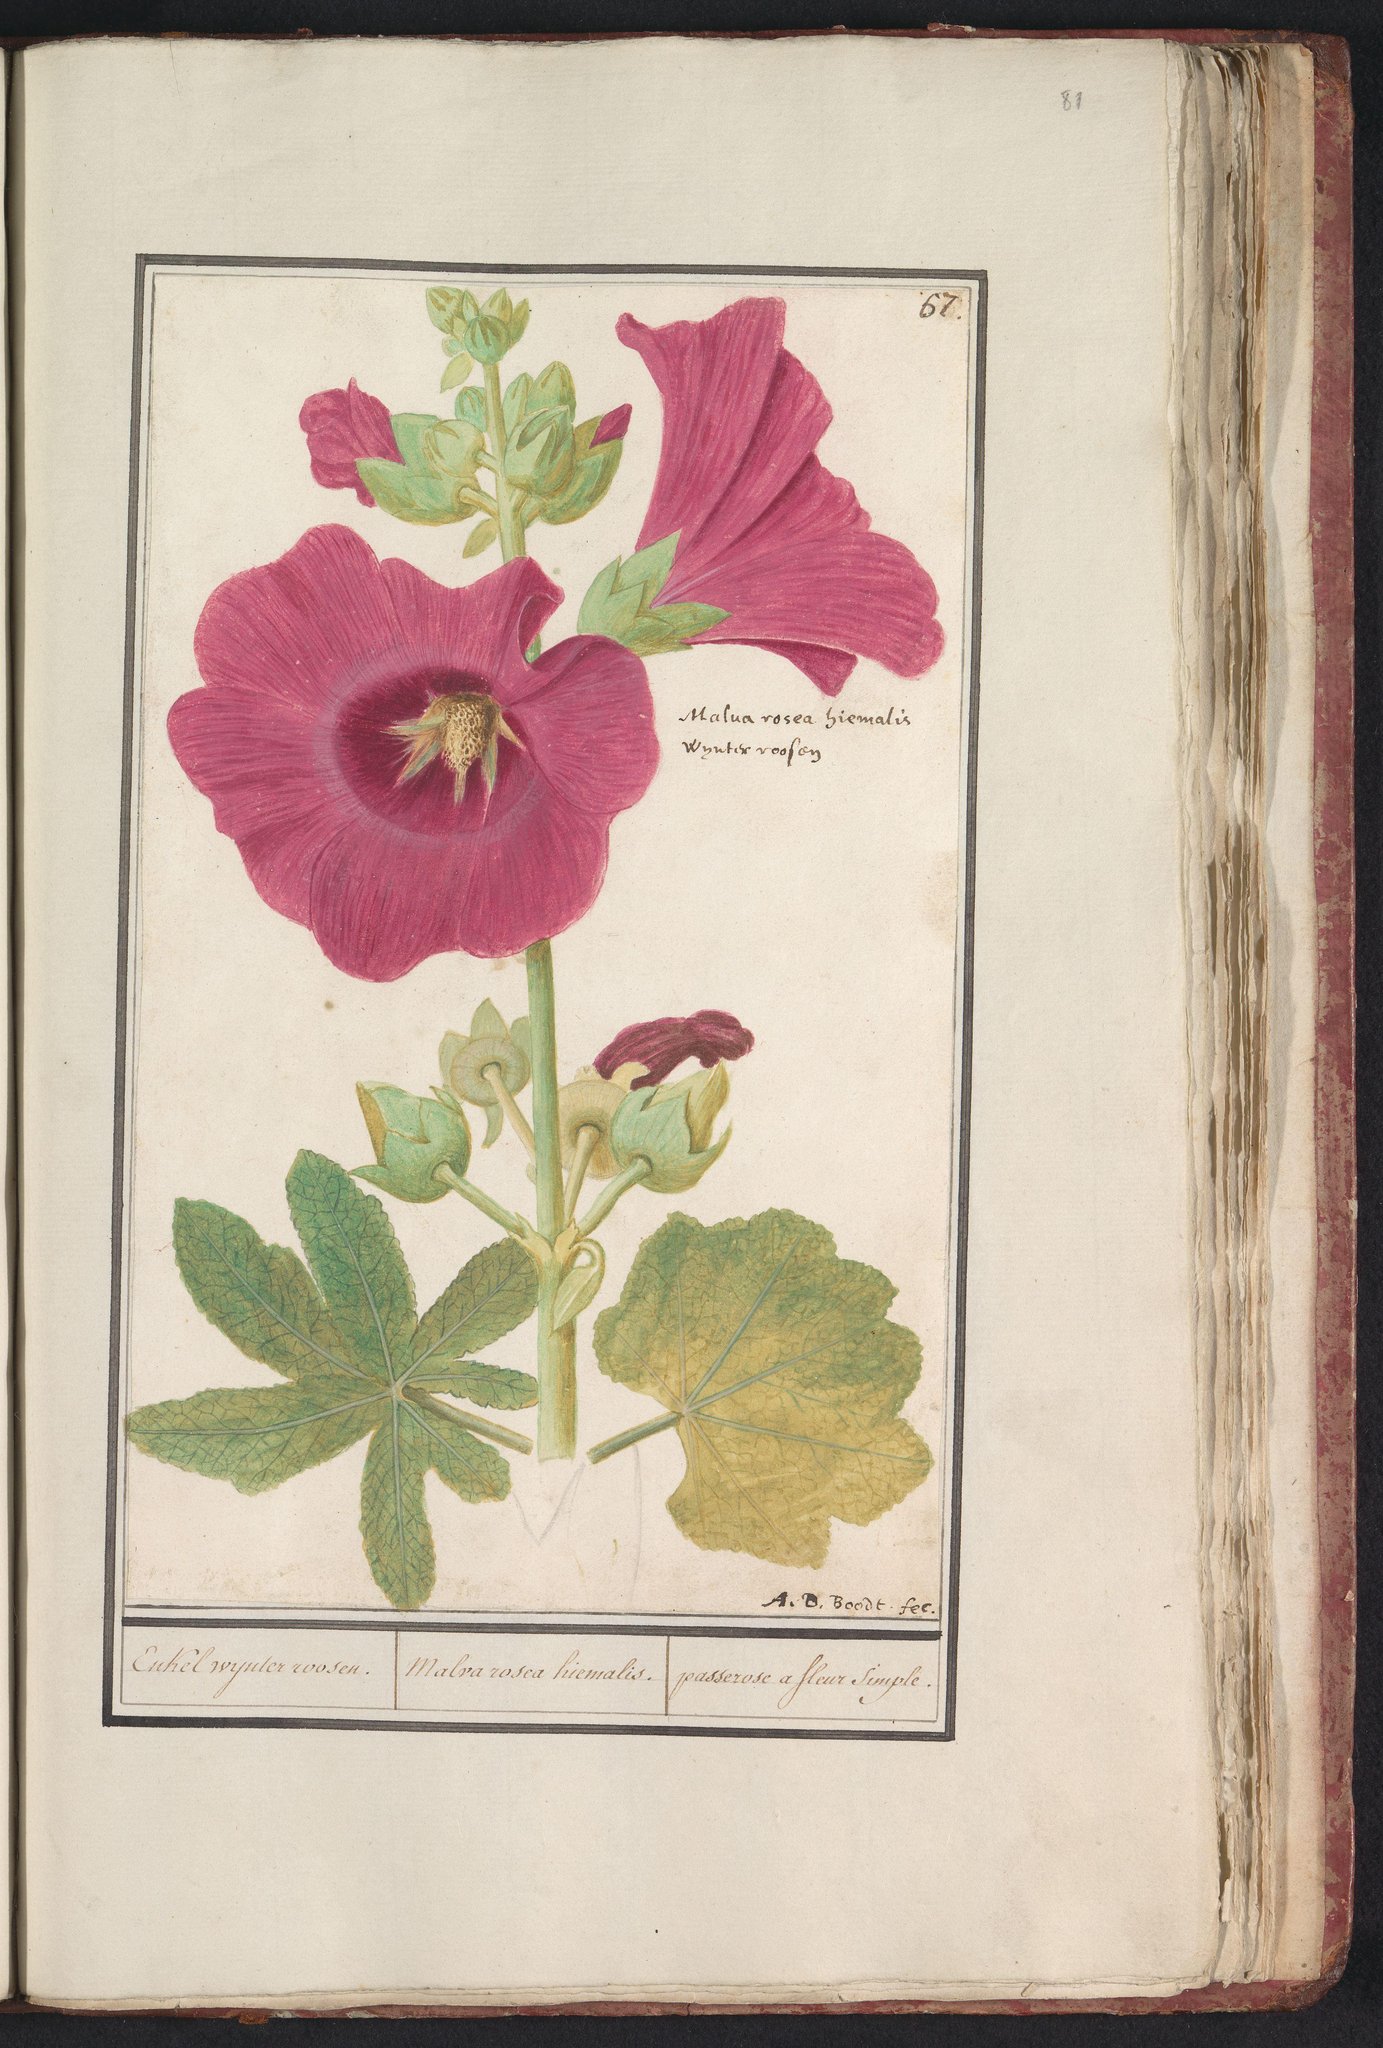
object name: drawing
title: Hollyhock (Alcea rosea)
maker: anselmus boëtius de boodt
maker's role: draughtsman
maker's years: 1550-1632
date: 1596-1610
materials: chalk, paint, ink, paper, watercolor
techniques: brush, pen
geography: prague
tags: flowers: hollyhock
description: The botanical drawings in the albums were in part made by other artists. For example, De Boodt commissioned 200 drawings from the Delft floral painter Elias Verhulst. De Boodt later lamented that they had not all been drawn from live models. It was in fact common practice to copy drawings and prints. This hollyhock was most likely drawn by De Boodt himself, and probably from life.